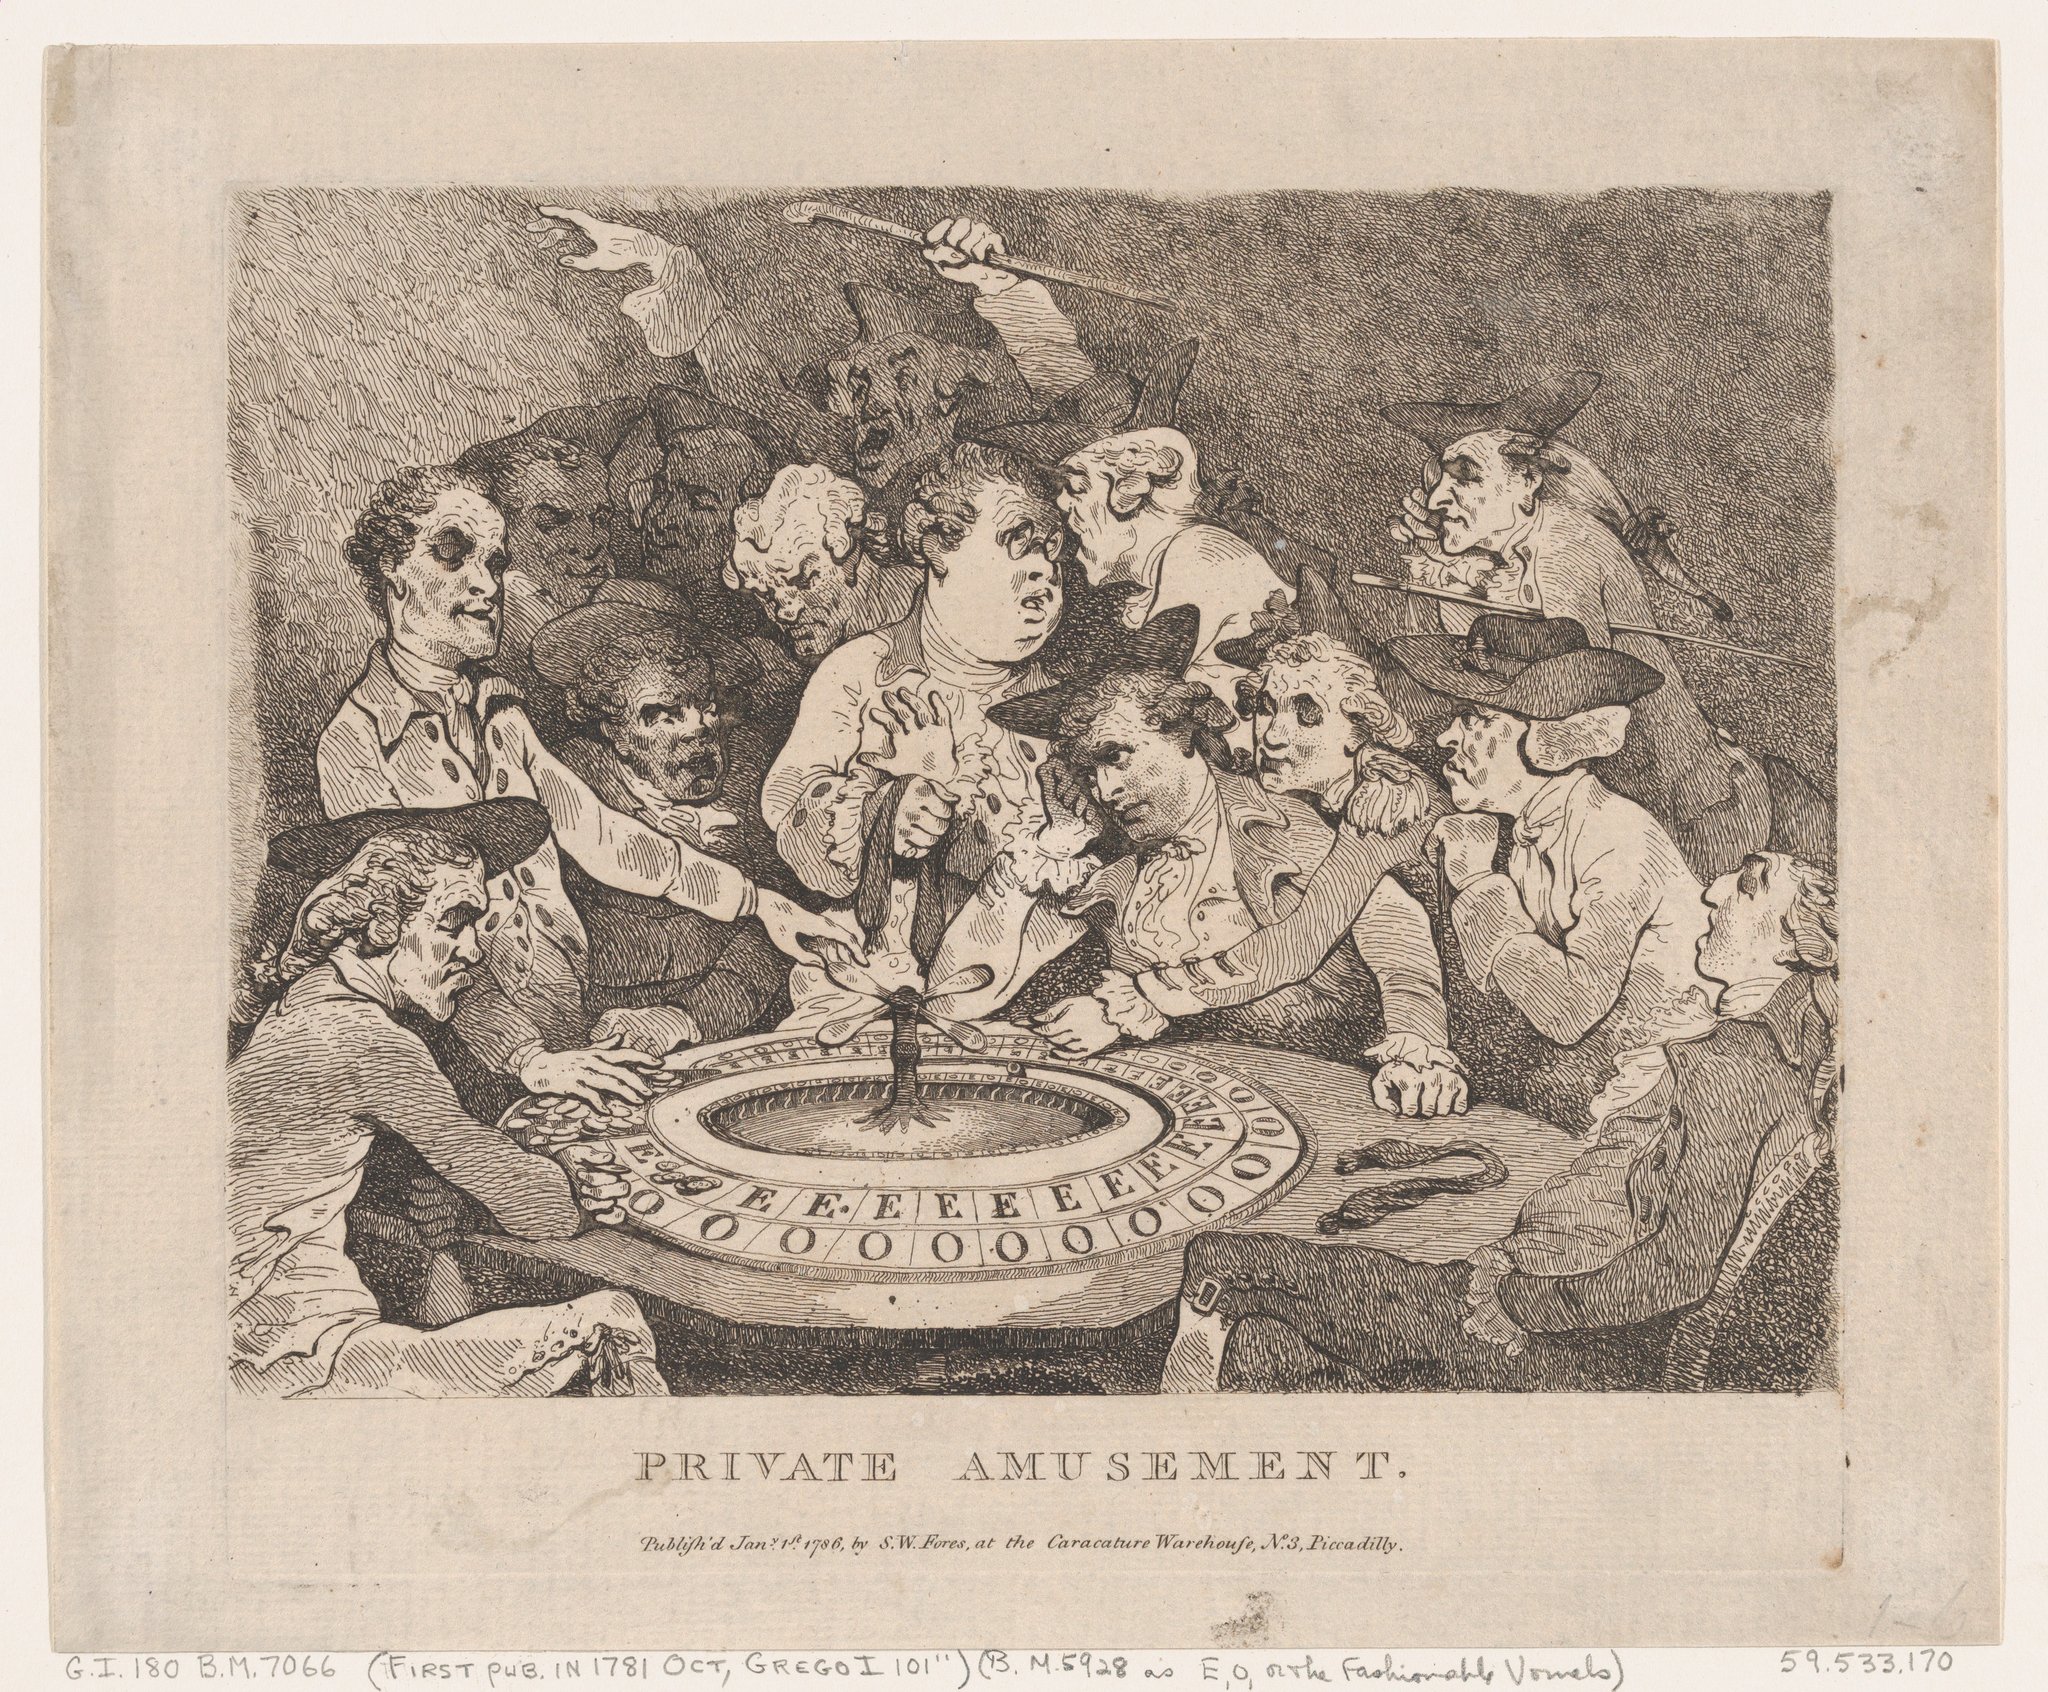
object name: print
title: Private Amusement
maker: thomas rowlandson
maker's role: artist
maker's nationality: british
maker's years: 1757-1827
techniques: etching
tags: men,entertainment